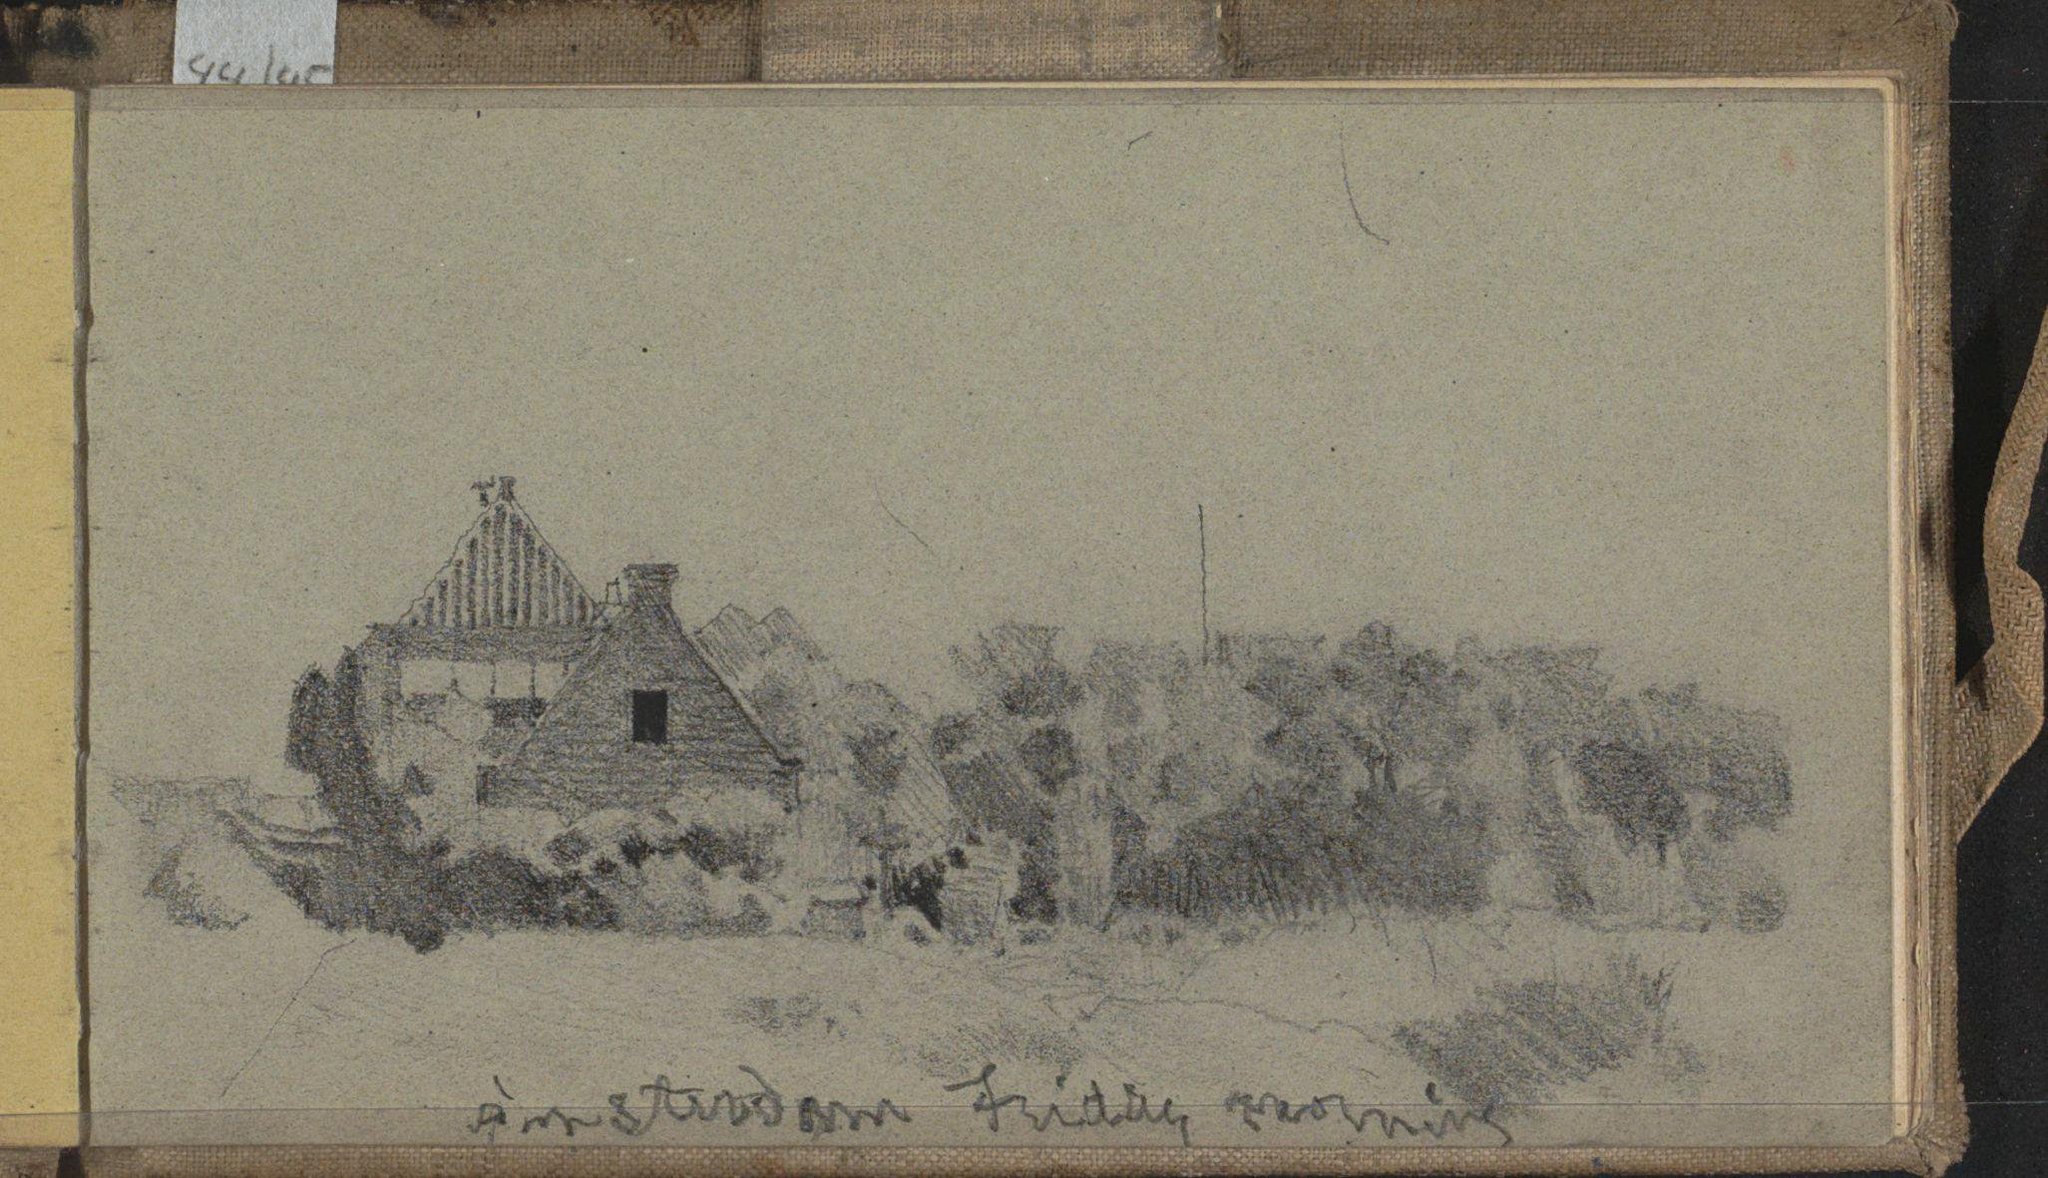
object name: sketchbook leaf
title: Huizen in Amsterdam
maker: george clausen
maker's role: draughtsman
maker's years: 1852-1912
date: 1875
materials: paper, pencil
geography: amsterdam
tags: city-view, and landscape with man-made constructions, amsterdam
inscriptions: annotation: ‘Amsterdam friday morning’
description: Blad 41 recto uit een schetsboek met 46 bladen.